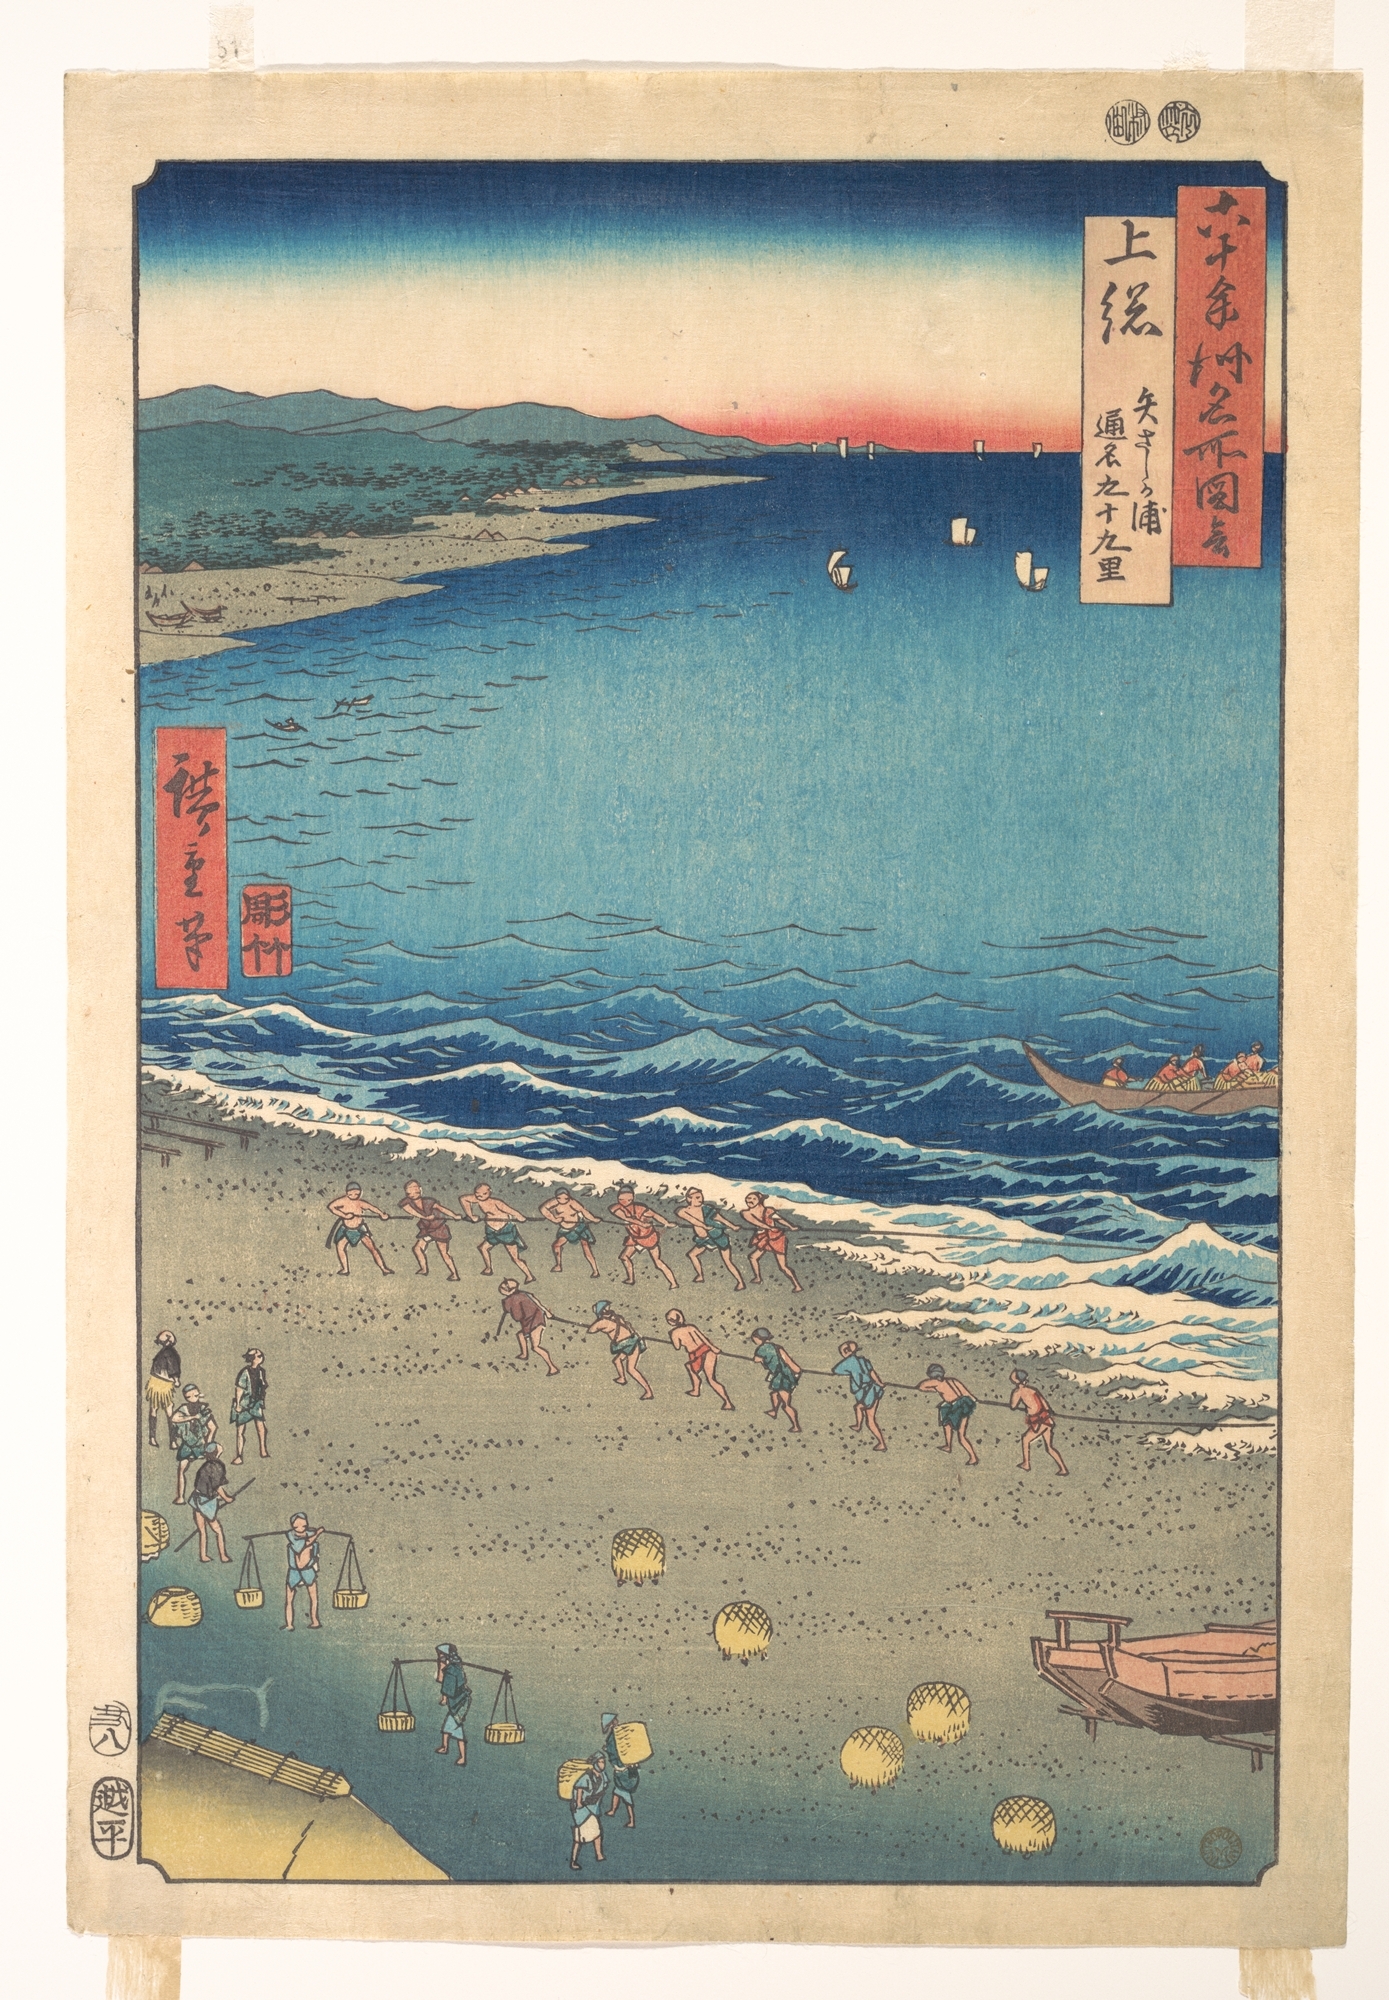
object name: print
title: Yasashi Beach, known as Kujūkuri, Kazusa Province, from the series Views of Famous Places in the Sixty-Odd Provinces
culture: japanese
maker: utagawa hiroshige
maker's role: artist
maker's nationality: japanese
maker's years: 1797-1858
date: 1853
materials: ink, paper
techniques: woodblock print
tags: human figures,beaches,boats